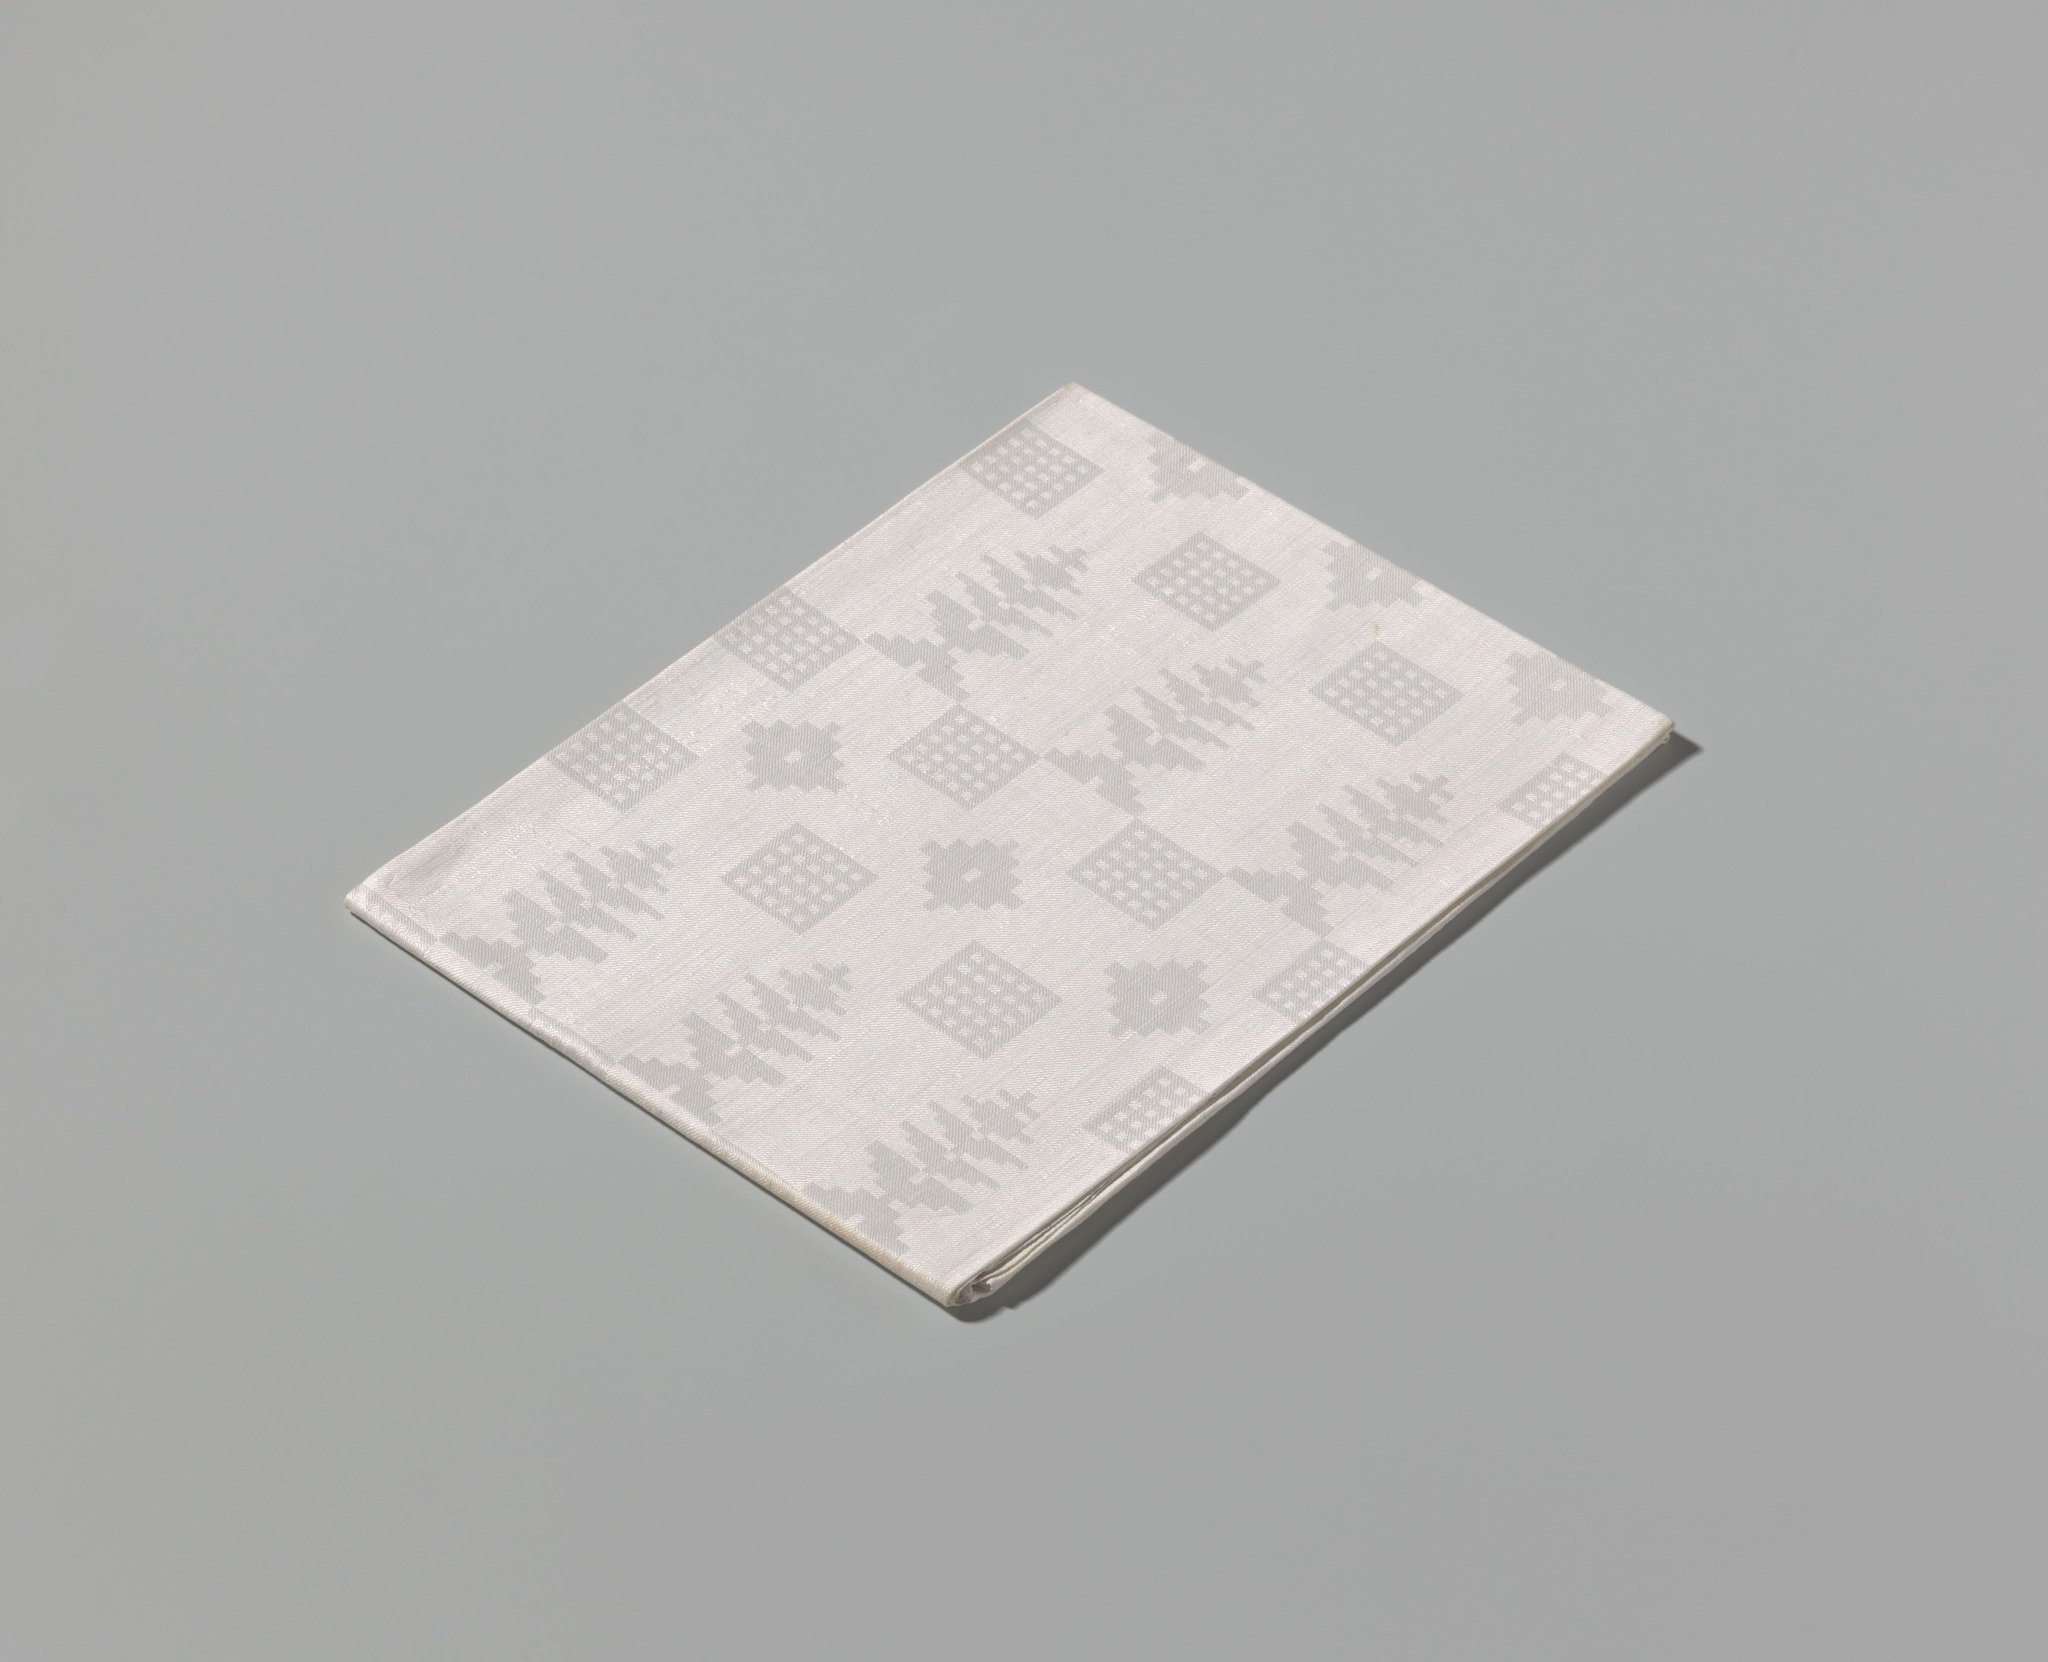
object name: napkin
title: Servet van linnen met pellenpatroon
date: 1730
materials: linen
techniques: twill, peeled fabric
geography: northern netherlands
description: wit linnen servet met pellen patroon, merk kroon WG 42 en 1730